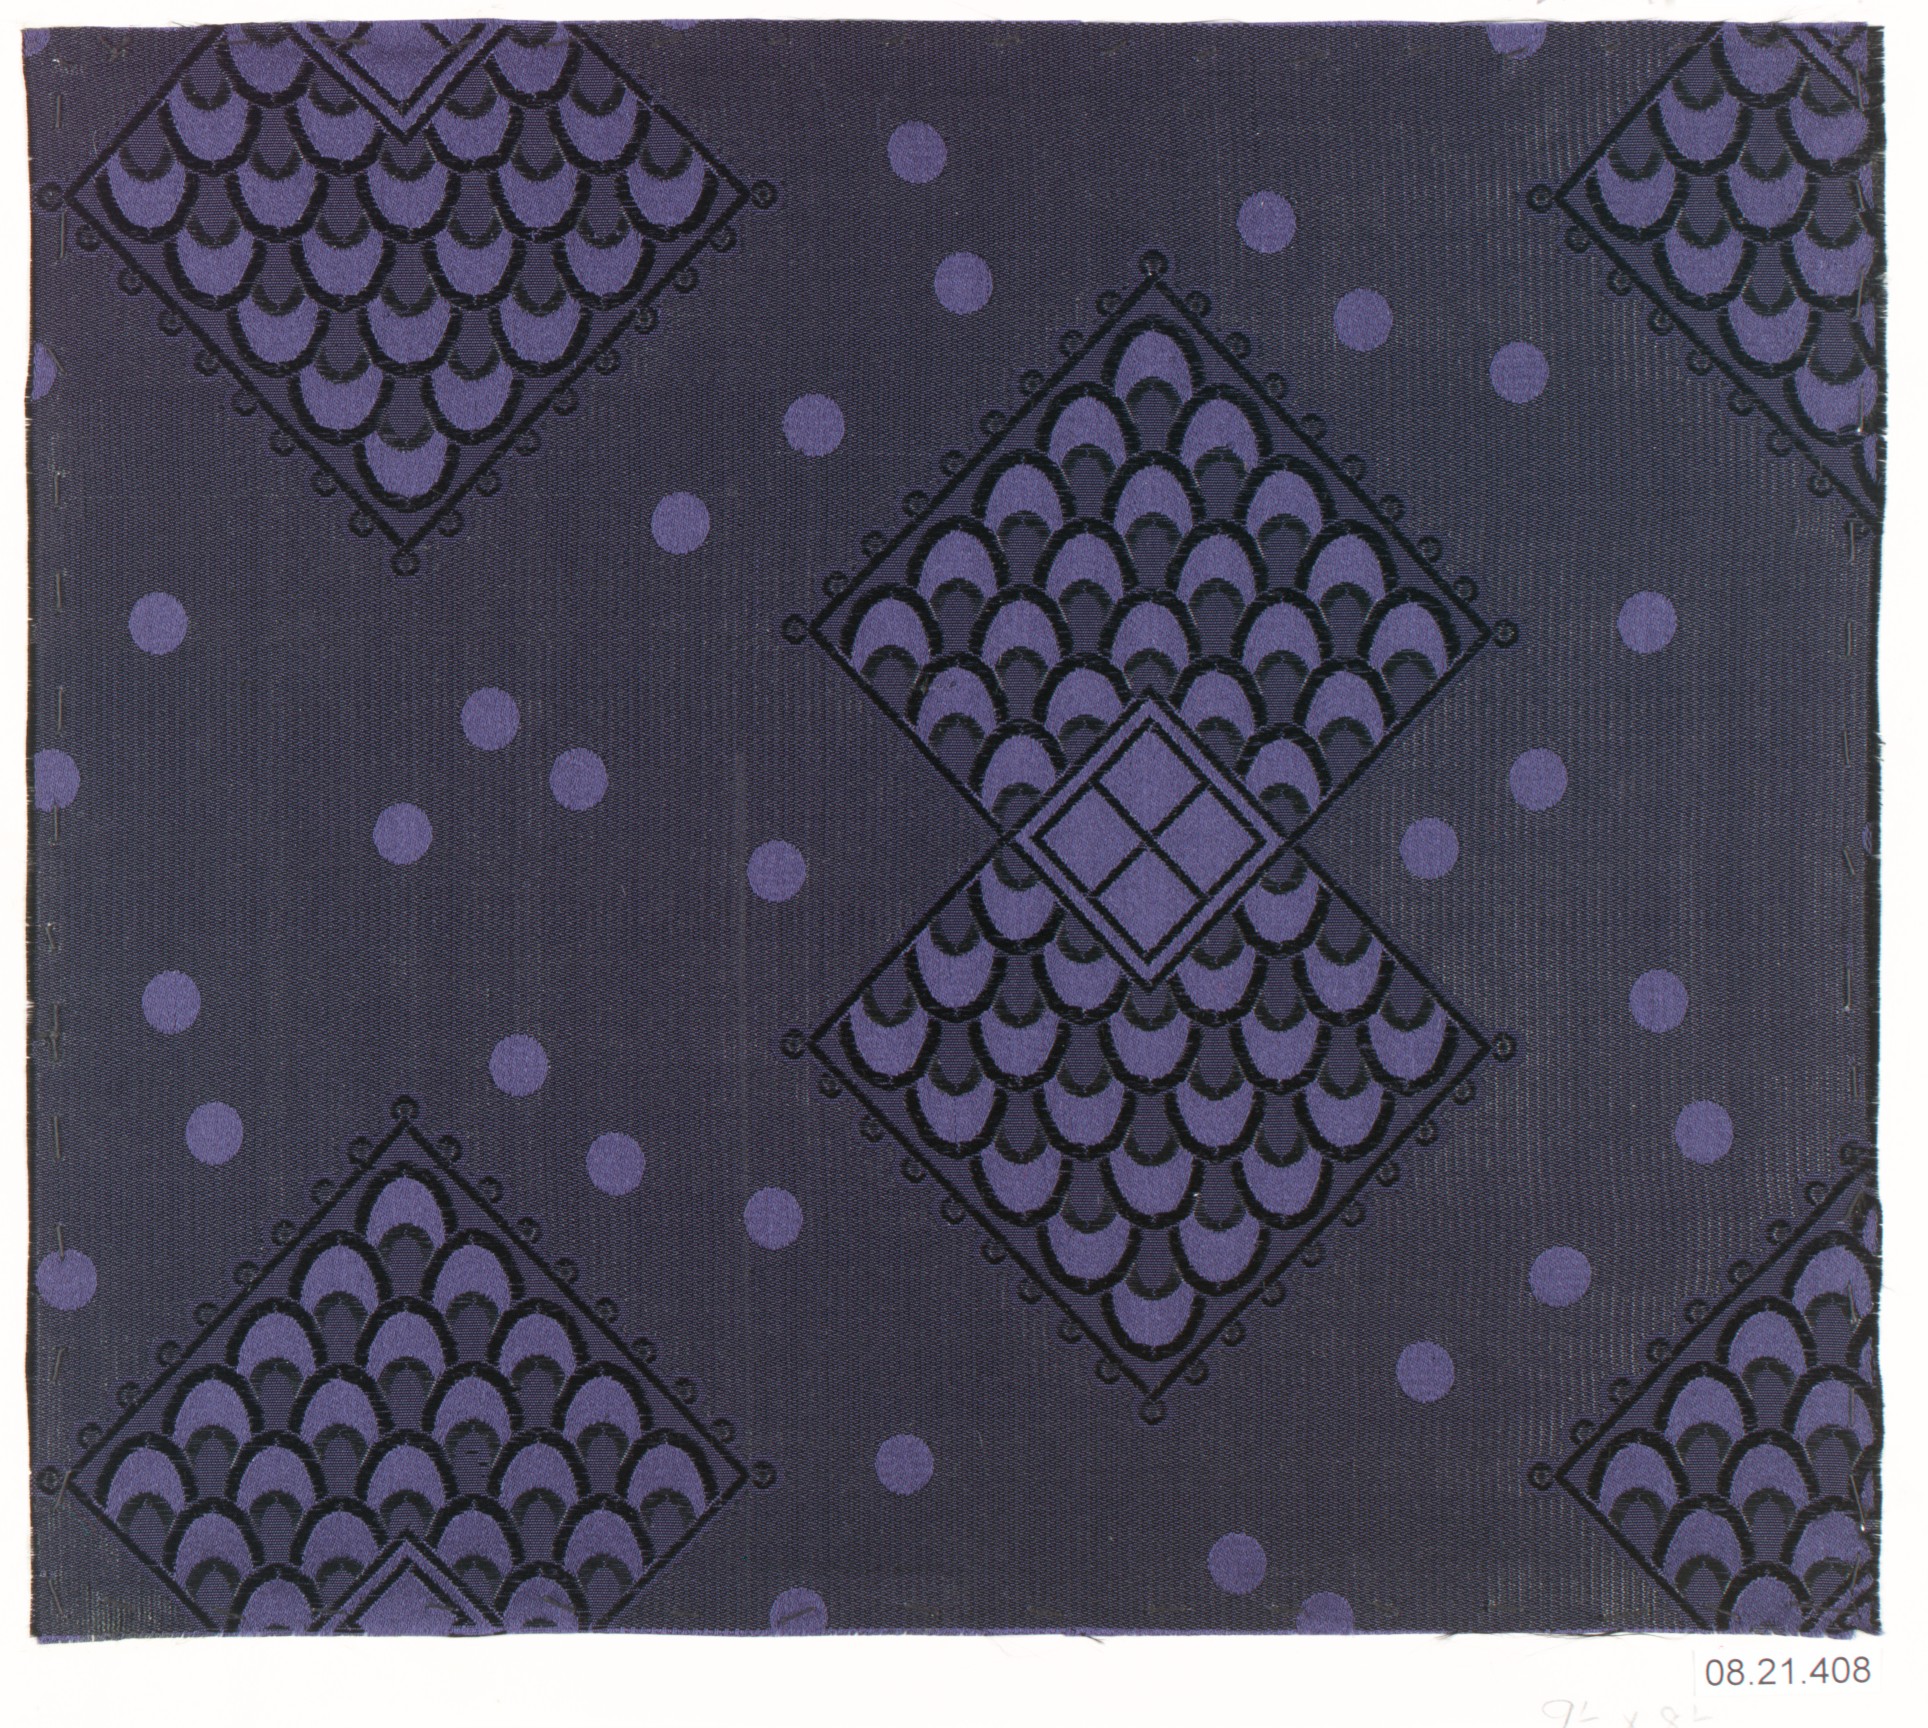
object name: textile sample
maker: Anonymous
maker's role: designer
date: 1900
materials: silk